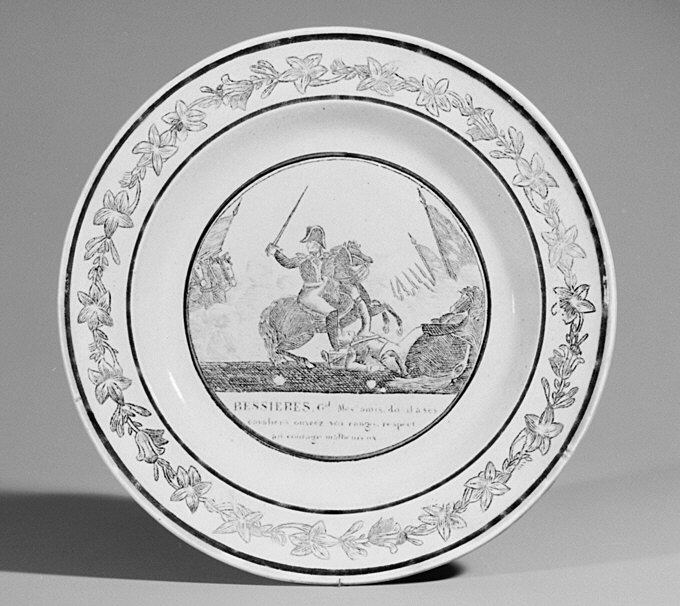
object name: plate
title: Plate (one of a set of five)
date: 1801-1900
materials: earthenware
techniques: glazing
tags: swords,horses,flags